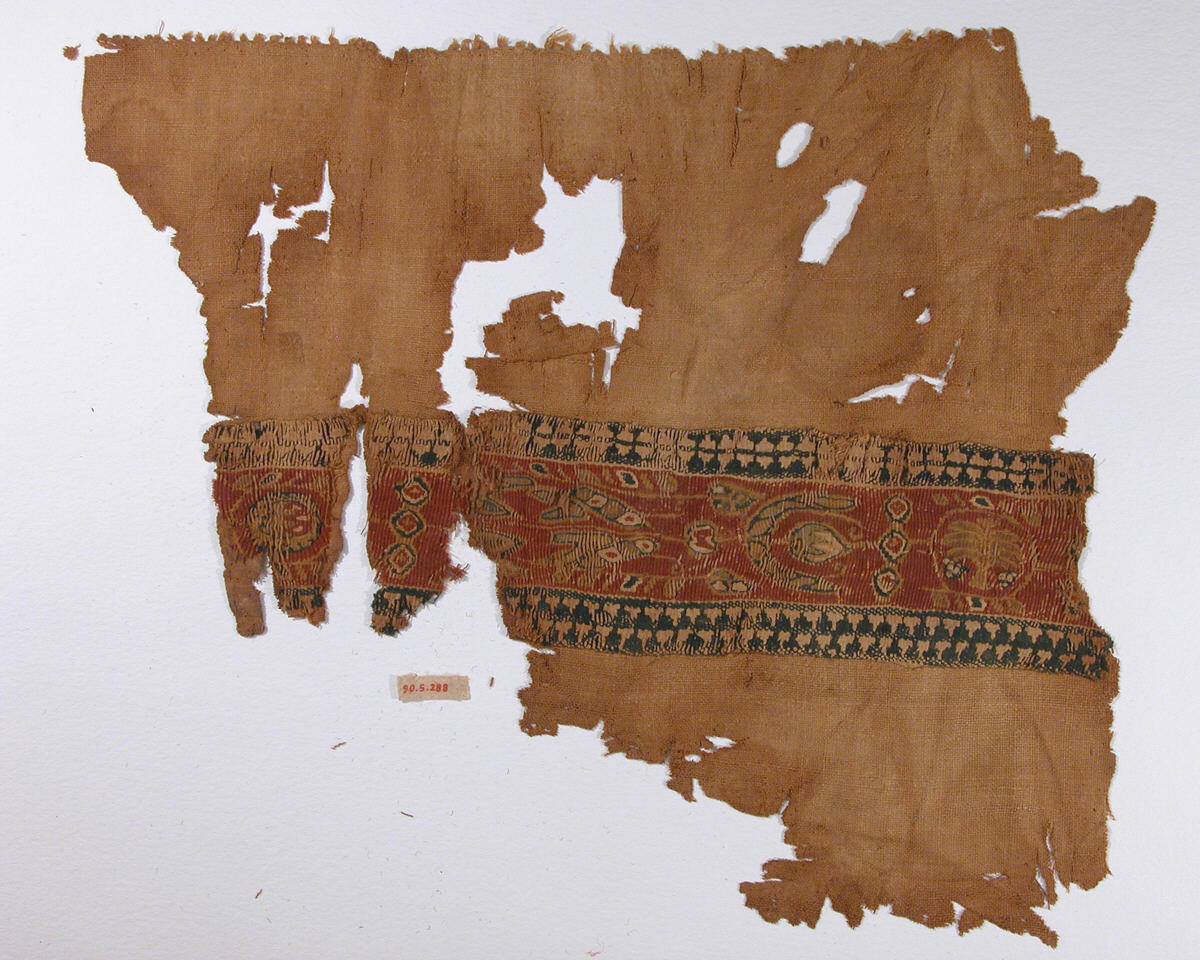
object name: textile fragment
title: Fragment of a Tunic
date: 501-700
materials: linen, wool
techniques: weave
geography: egypt